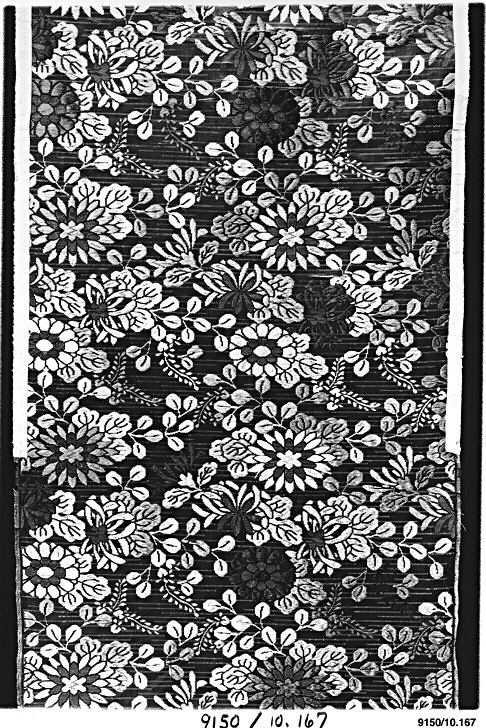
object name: piece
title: Four Pieces for Obi (?)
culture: japanese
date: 1801-1900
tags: flowers